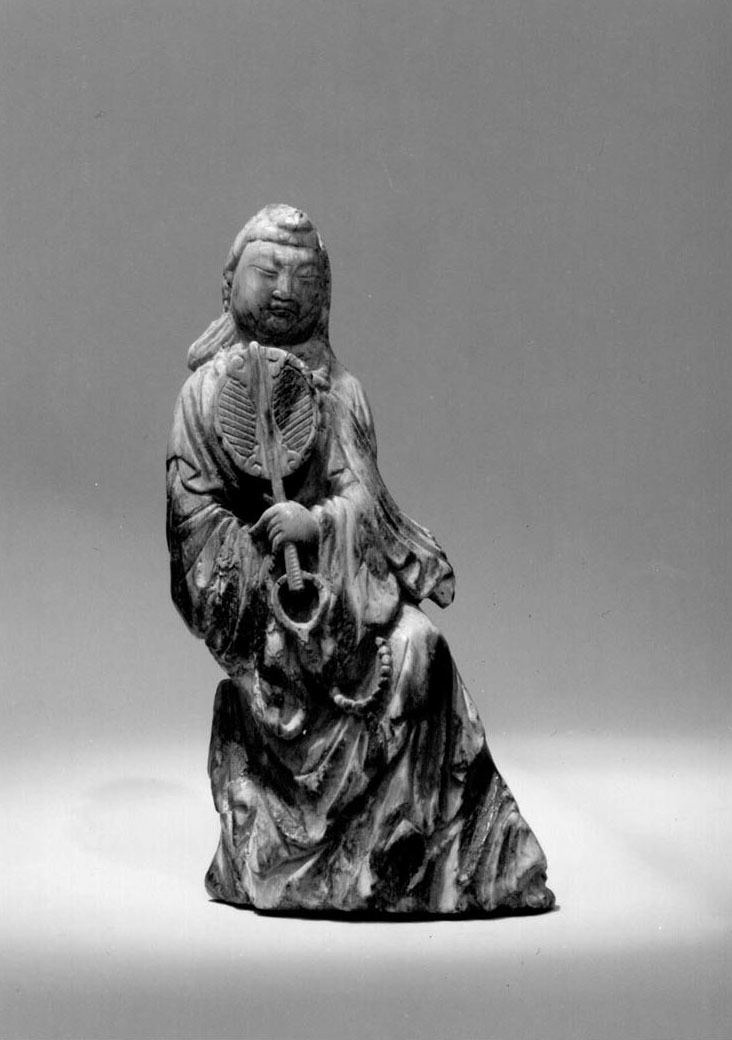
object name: figure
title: Guanyin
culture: chinese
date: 618-907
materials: ivory, wood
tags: buddhism,bodhisattvas